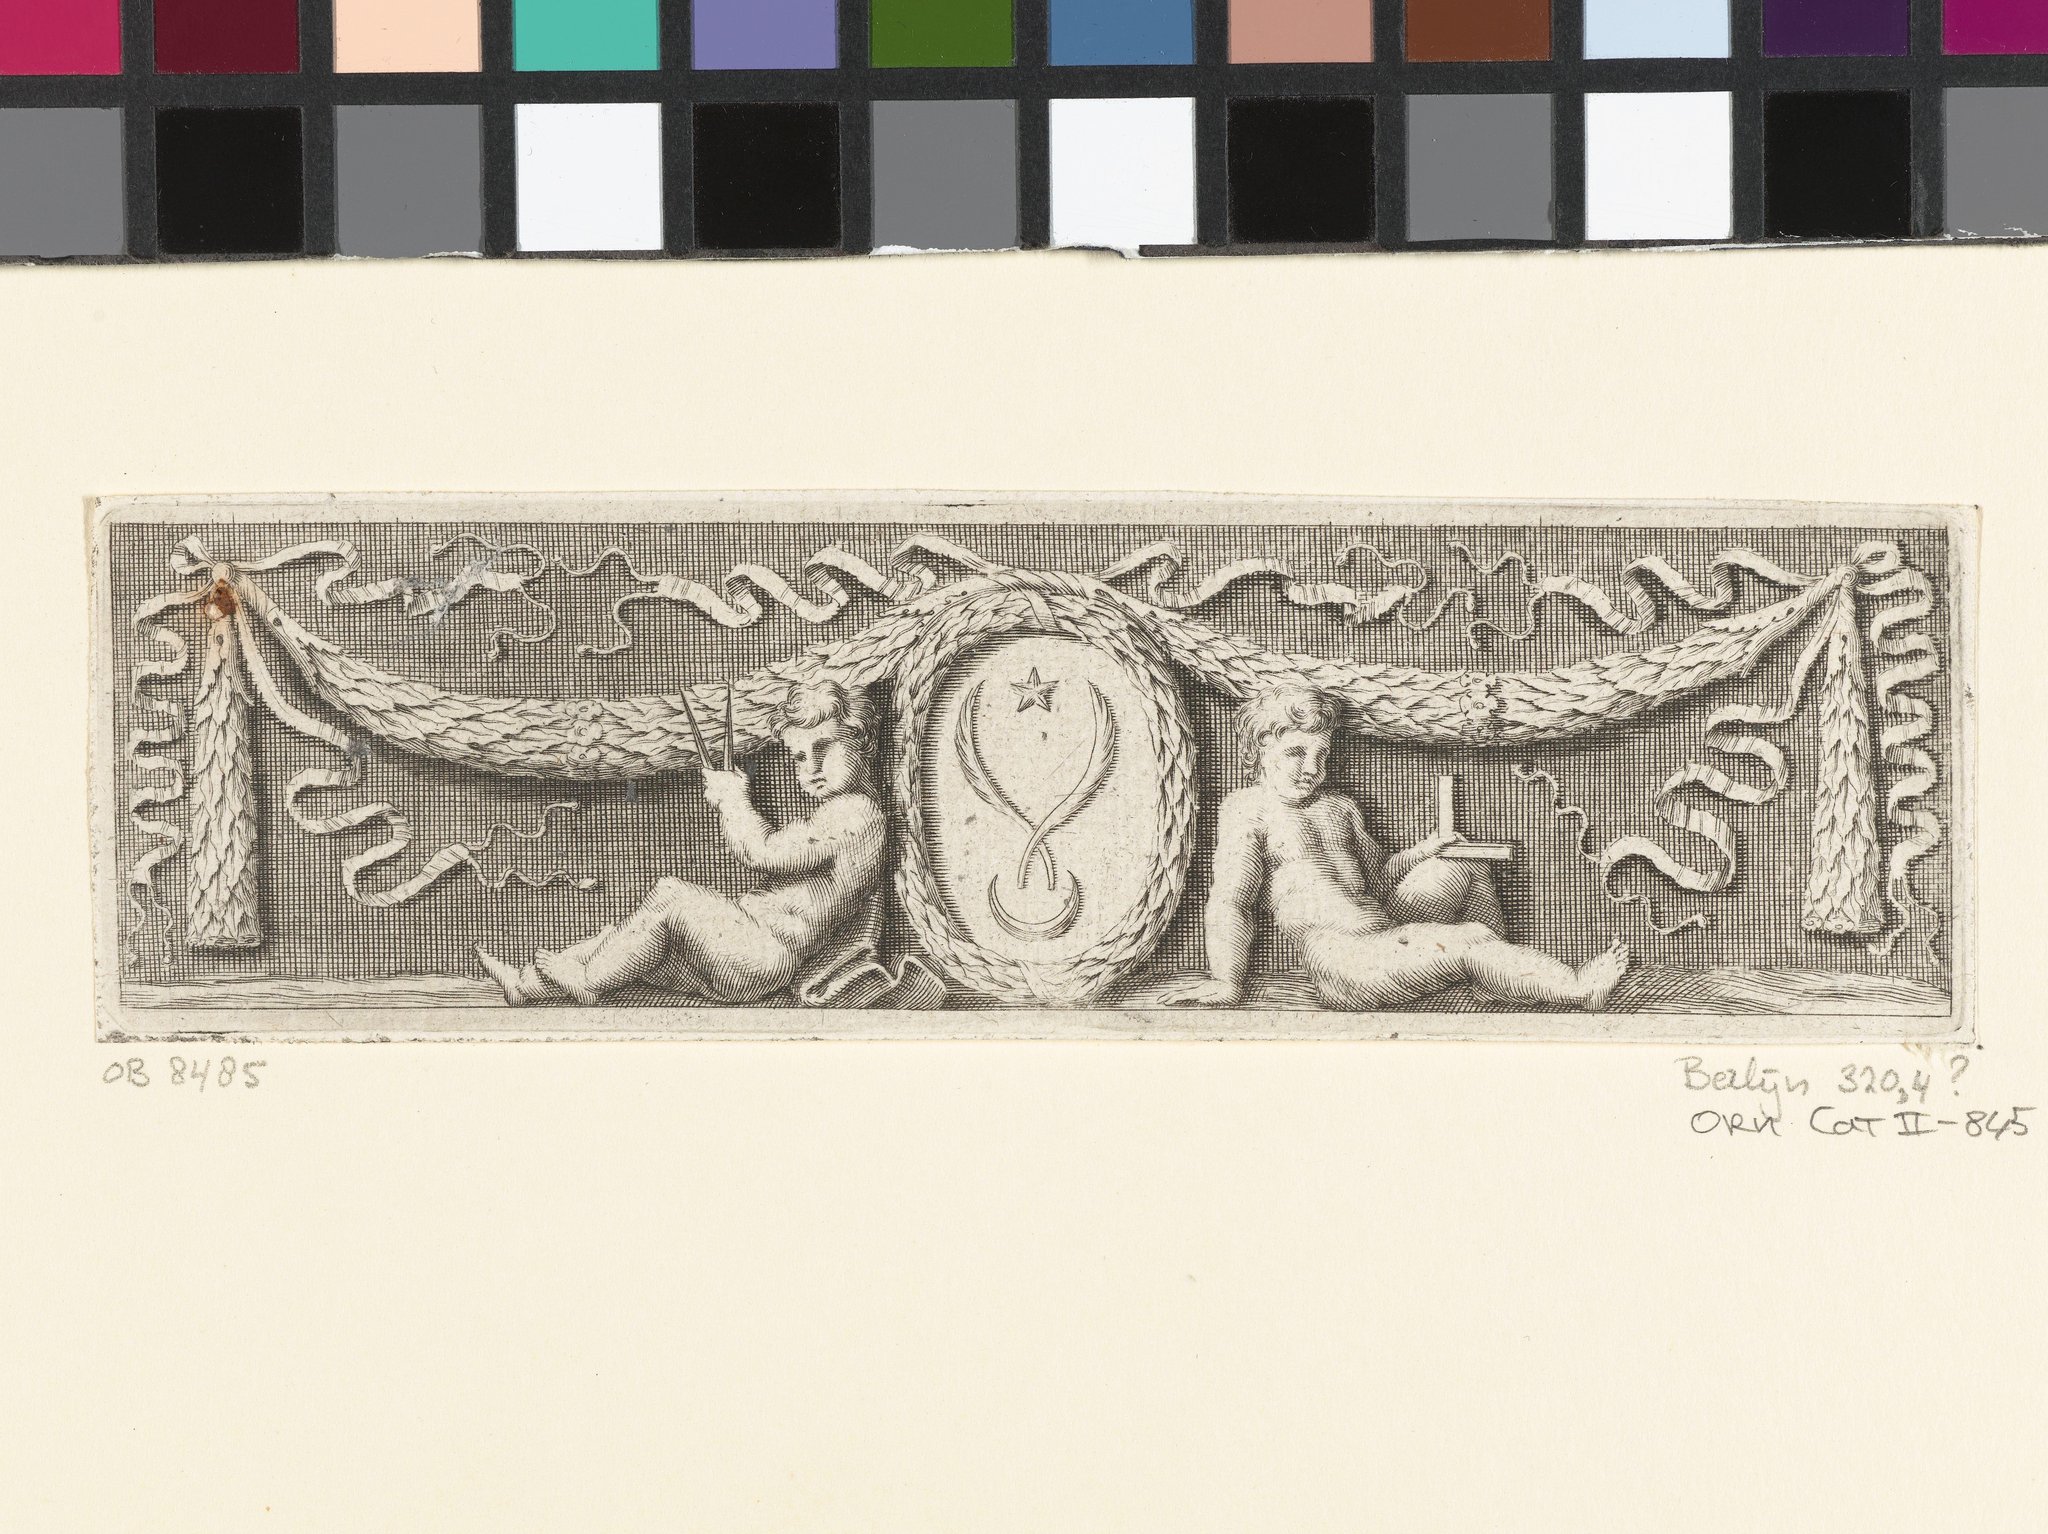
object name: print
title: Vignetten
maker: Anonymous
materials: paper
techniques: engraving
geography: paris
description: Vignet. De ene putto heeft een passer vast, de andere een rechthoek. In het medaillon staan twee gekruiste palmbladeren, een ster en een halve maan.